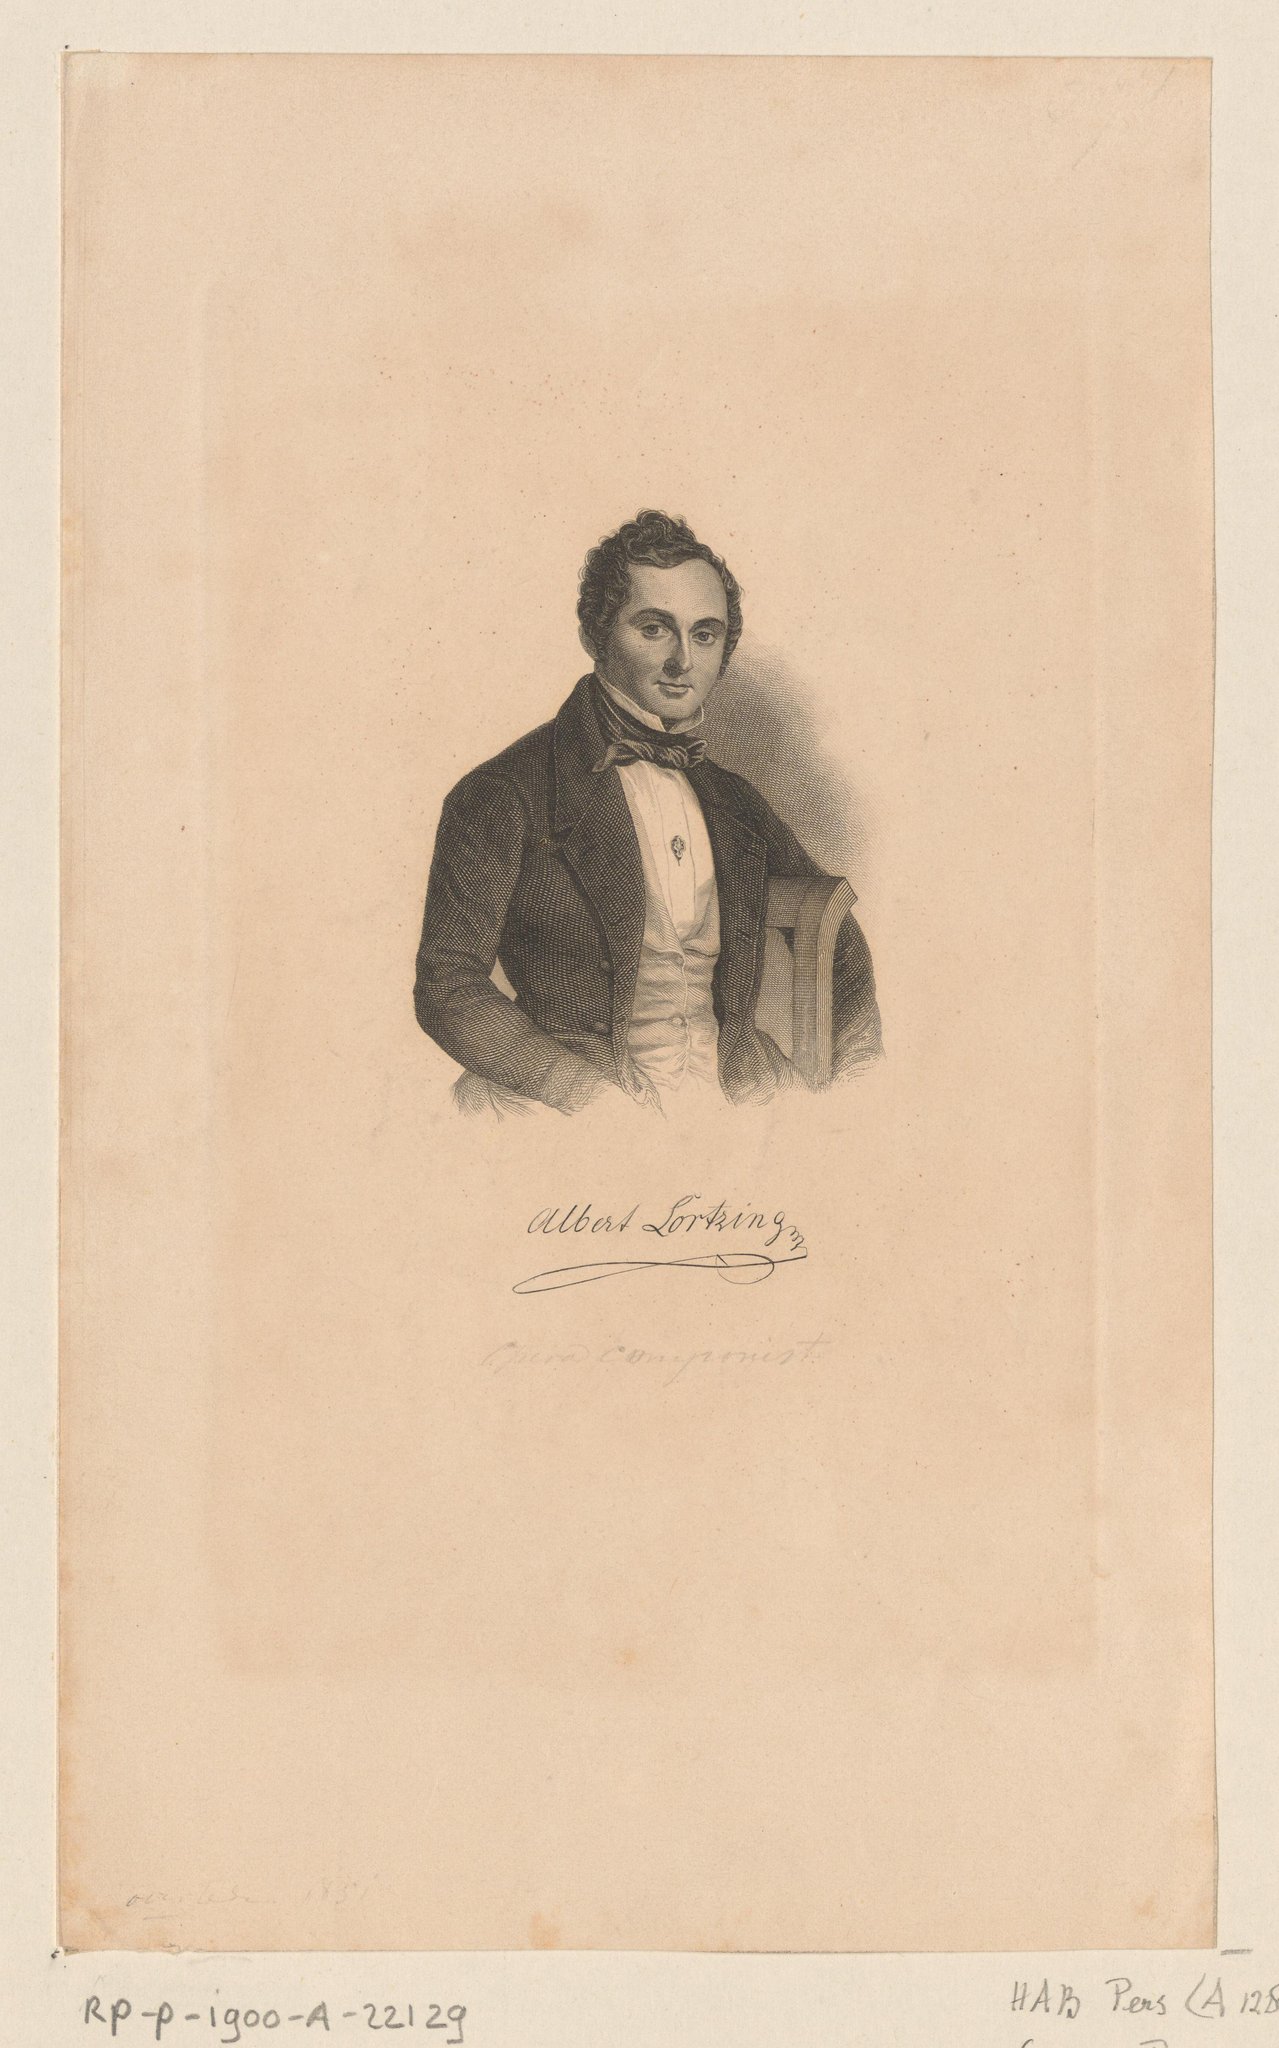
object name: print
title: Portret van Albert Lortzing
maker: Anonymous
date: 1820-1899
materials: paper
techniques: engraving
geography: germany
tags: historical persons, portrait of composer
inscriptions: collector's mark: Lugt 2228